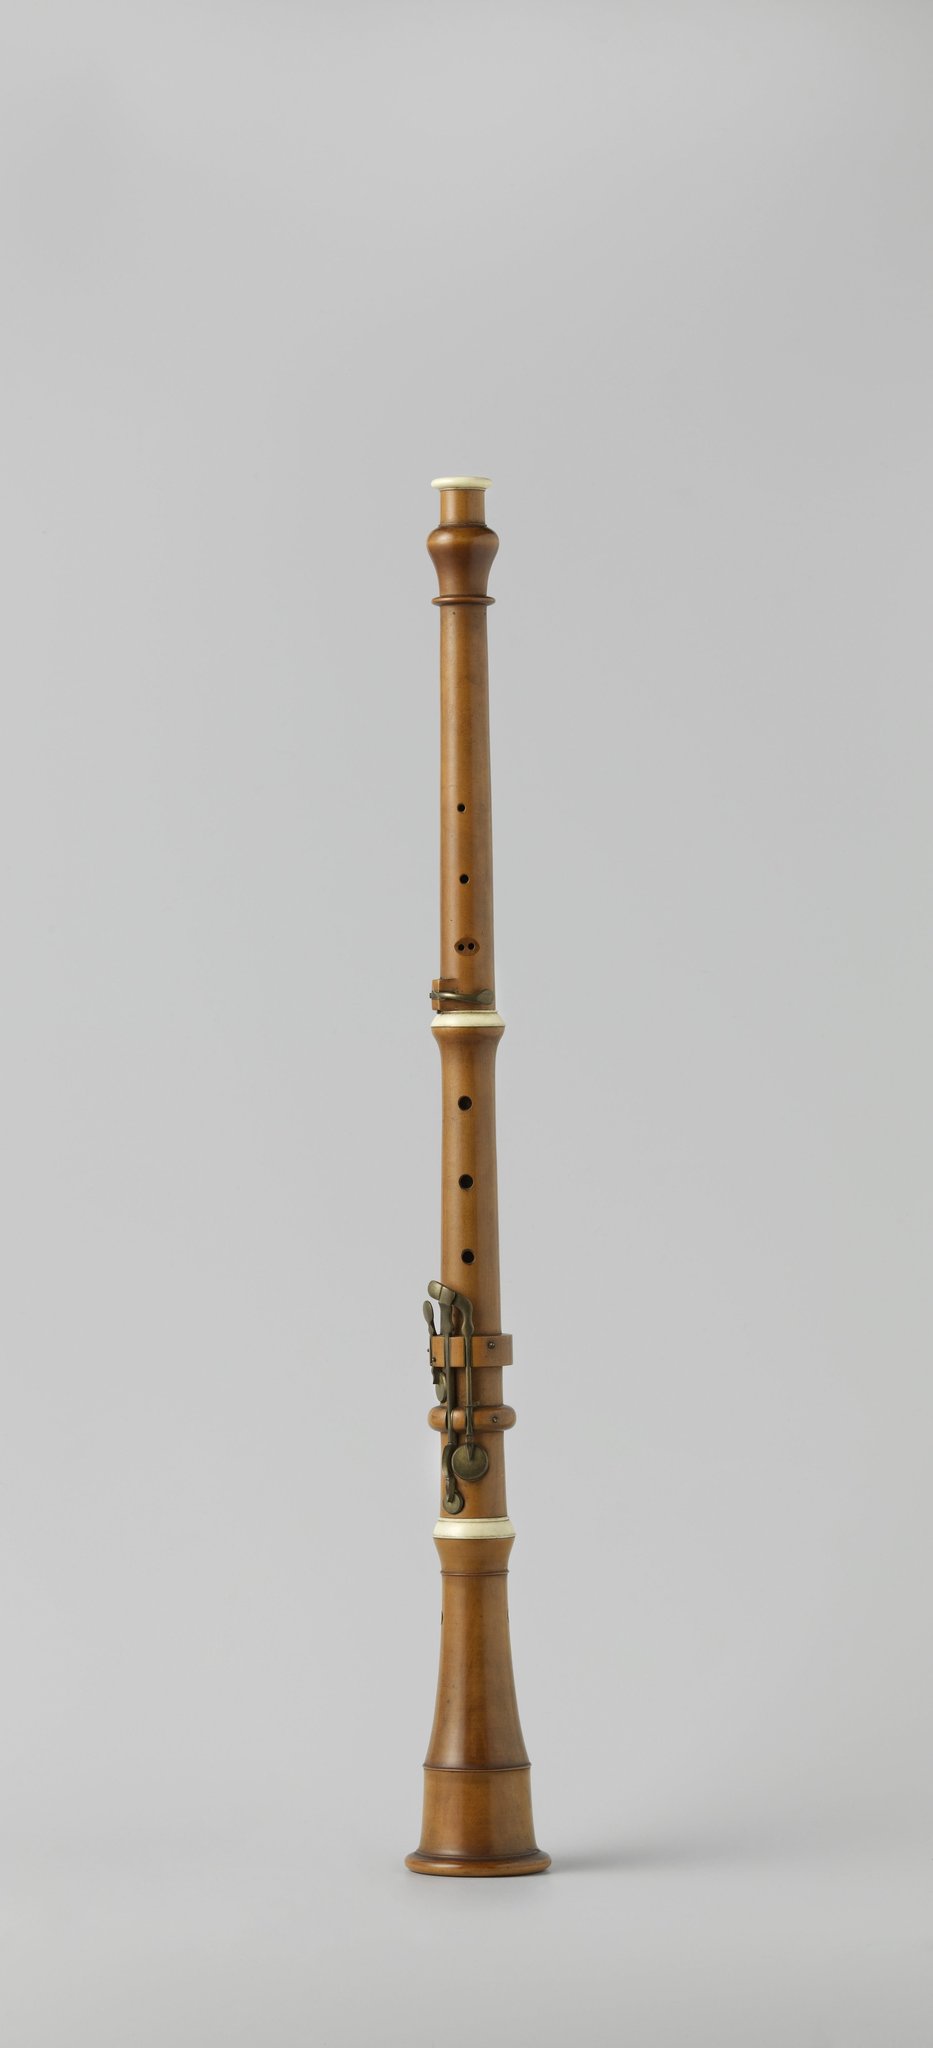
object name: musical instrument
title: Oboe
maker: Anonymous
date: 1800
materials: wood, brass, ivory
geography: germany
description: Hobo van palmhout met drie ivoren ringen en vier kleppen.